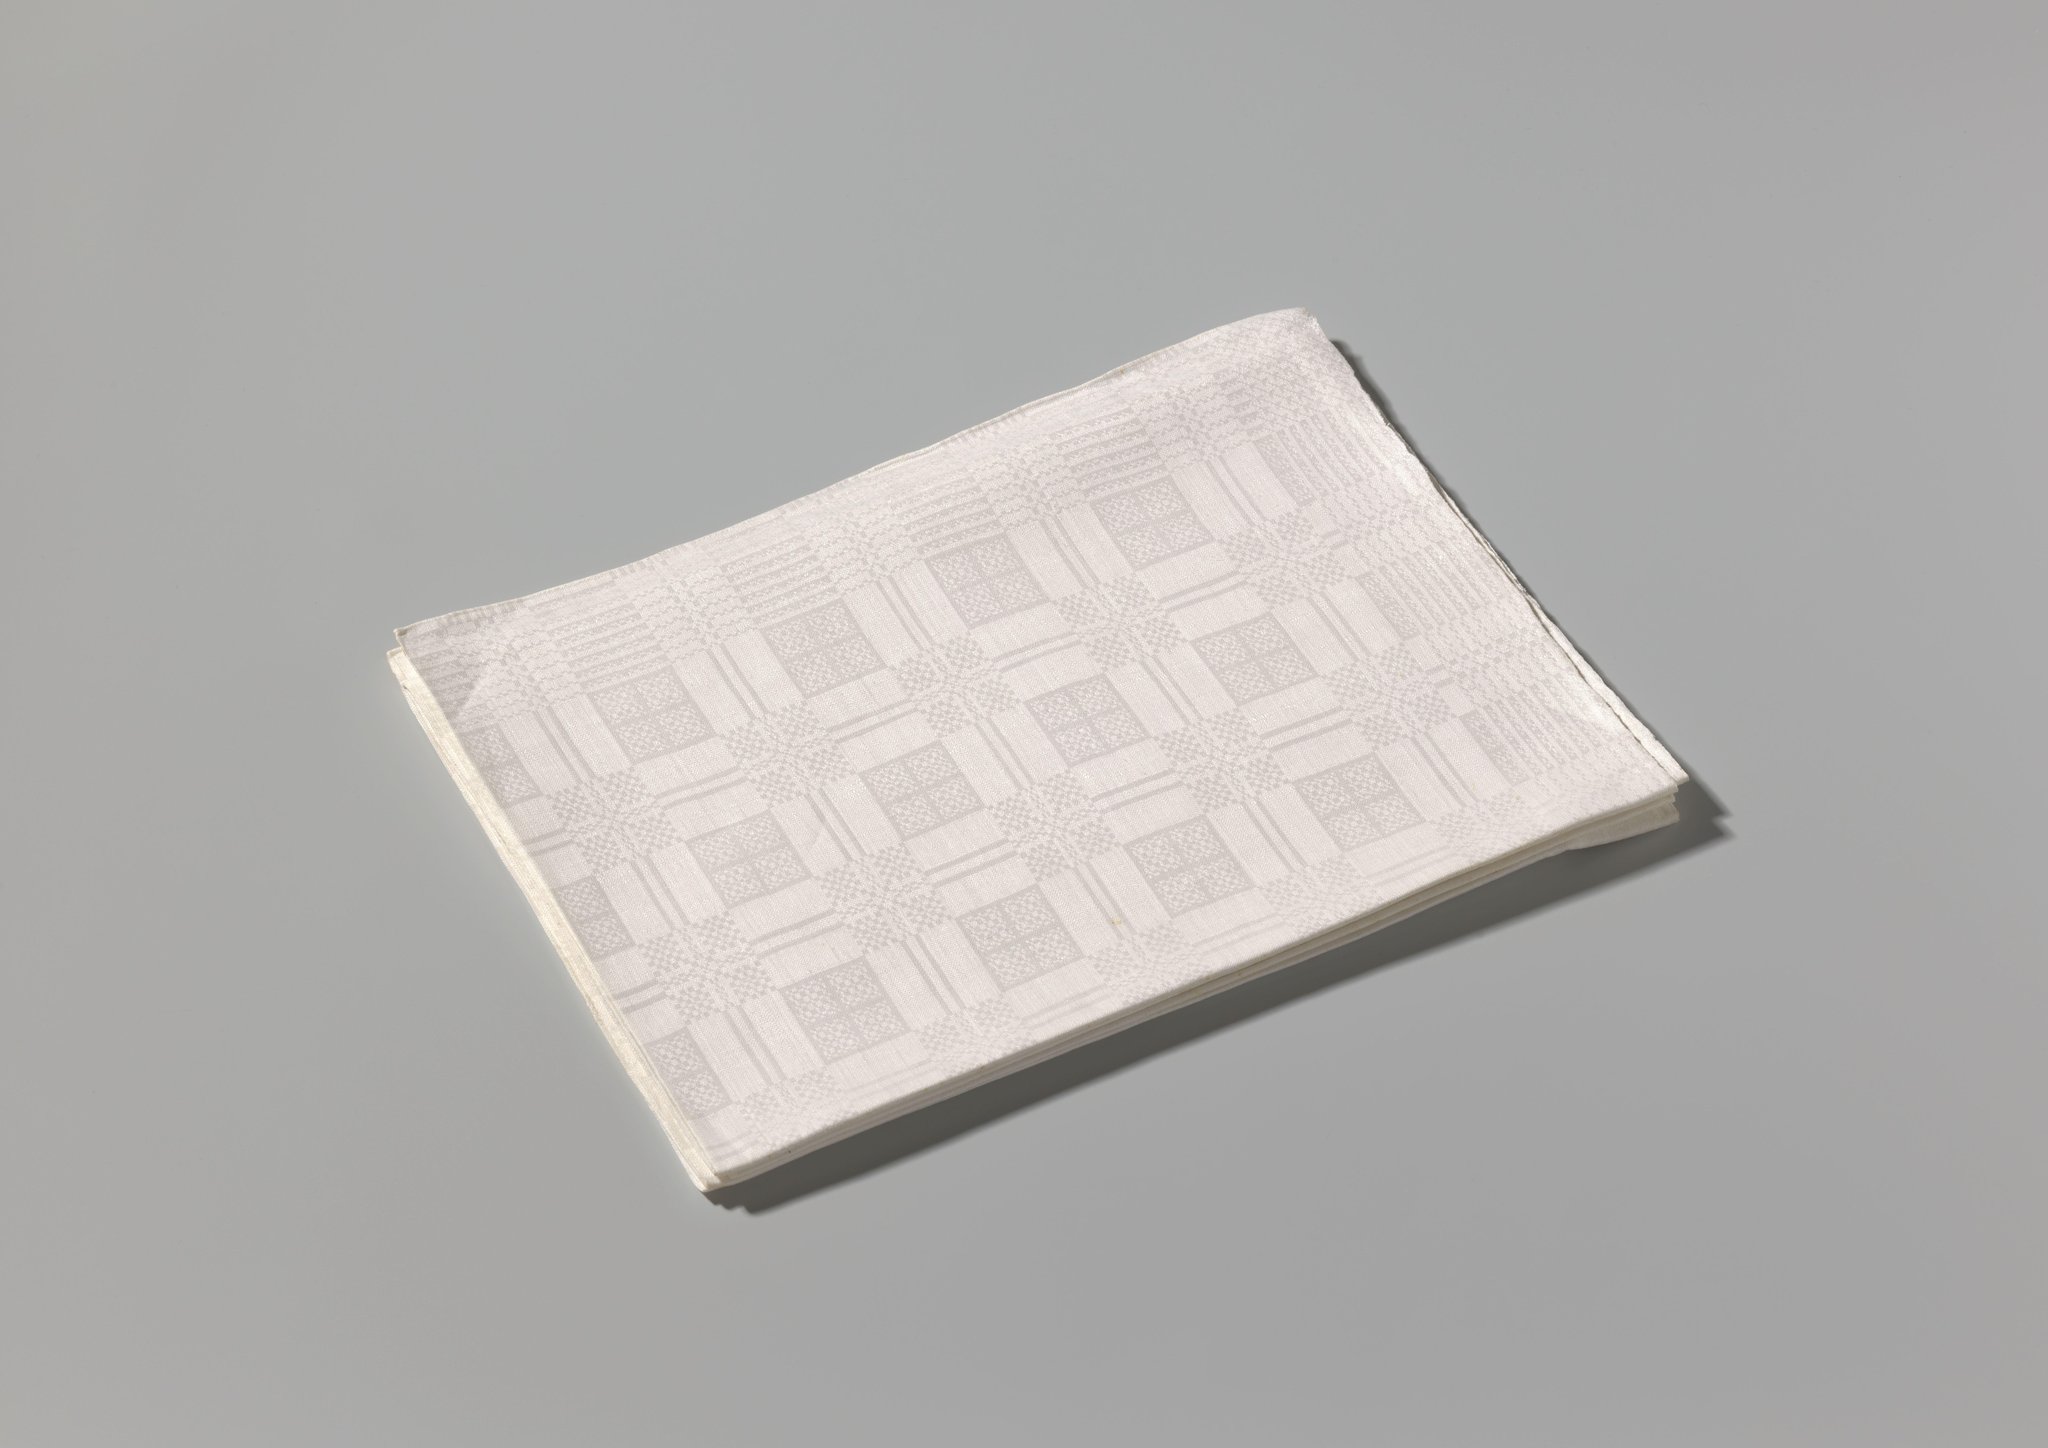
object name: tablecloth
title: Tafellaken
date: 1700-1799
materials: linen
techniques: peeled fabric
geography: netherlands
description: Wit linnen tafellaken met een pellen patroon in kruiskeper, merk kroon G 4 WH 2oonl.